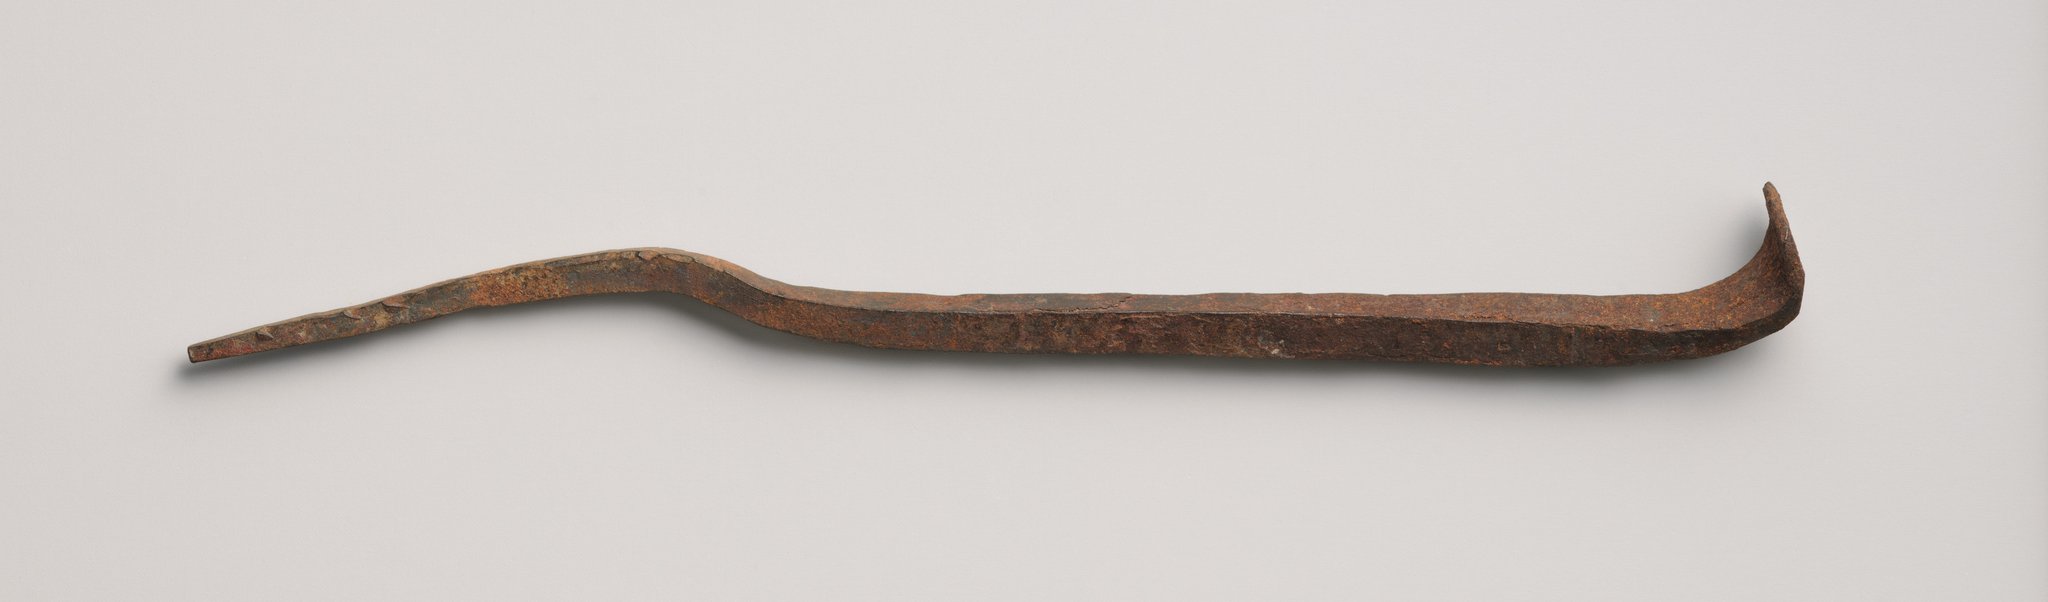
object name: key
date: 306-30 BCE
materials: iron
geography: egypt